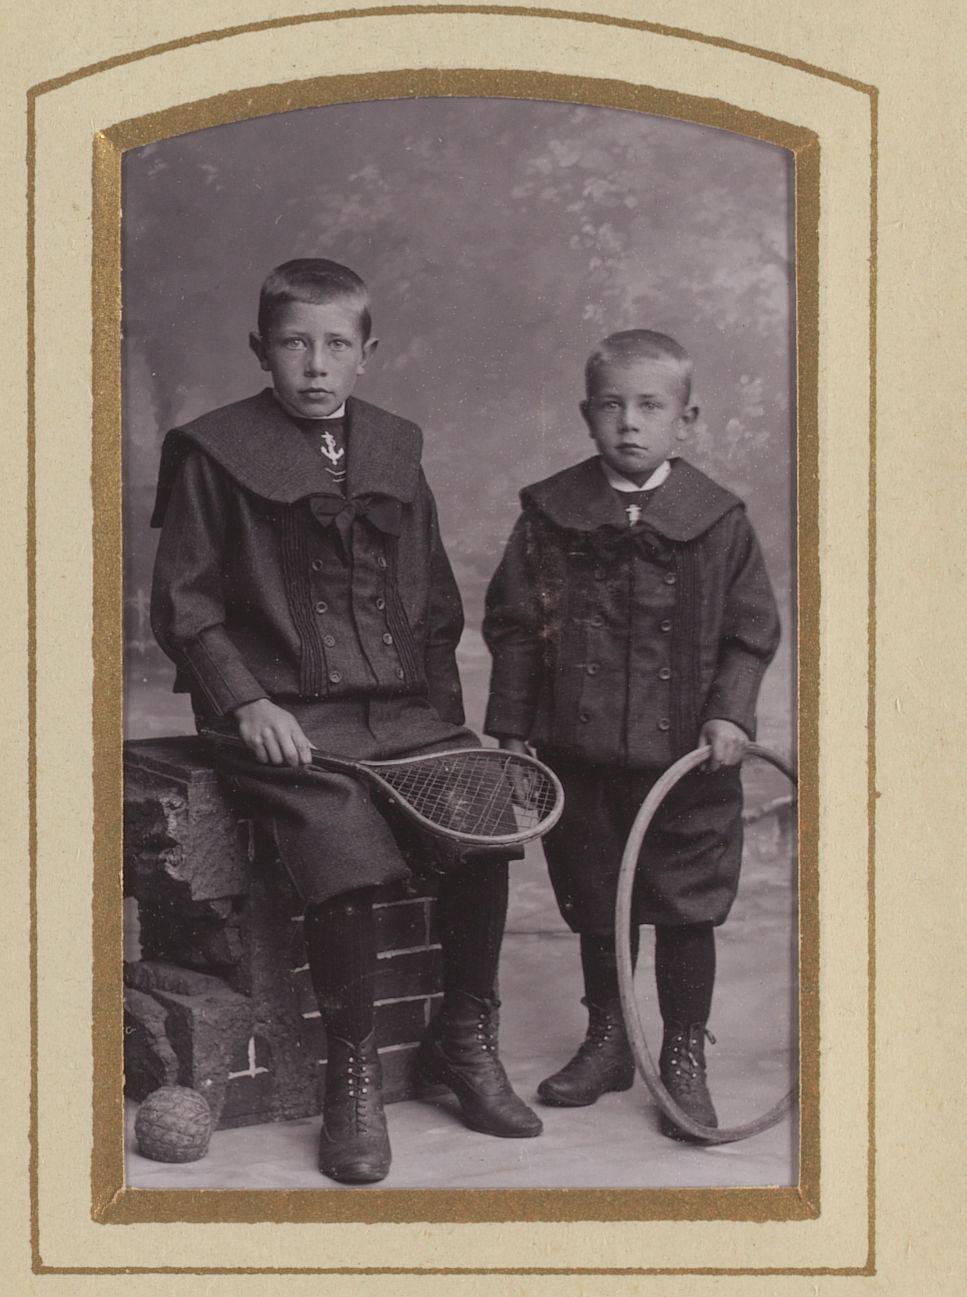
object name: album leaf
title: Portret van een jongen met tennisracket in de hand en een jongen met hoepel in de hand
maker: johannes laurens theodorus huijsen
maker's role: fotograaf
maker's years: 1852-1910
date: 1883-1910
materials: cardboard, photographic support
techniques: collodion silver print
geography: hoorn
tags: boy (child between toddler and youth) (+ two persons), historical persons, (bowling a) hoop, ball games in which ball is hit with racket (or hand)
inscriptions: inscription: ‘J.L.T. HUIJSEN/ Photographe/ Bekroond op verschillende/ Tentoonstellingen/ HOORN/ Ramen 17./ De plaat blijft ter nabestelling bewaard.’